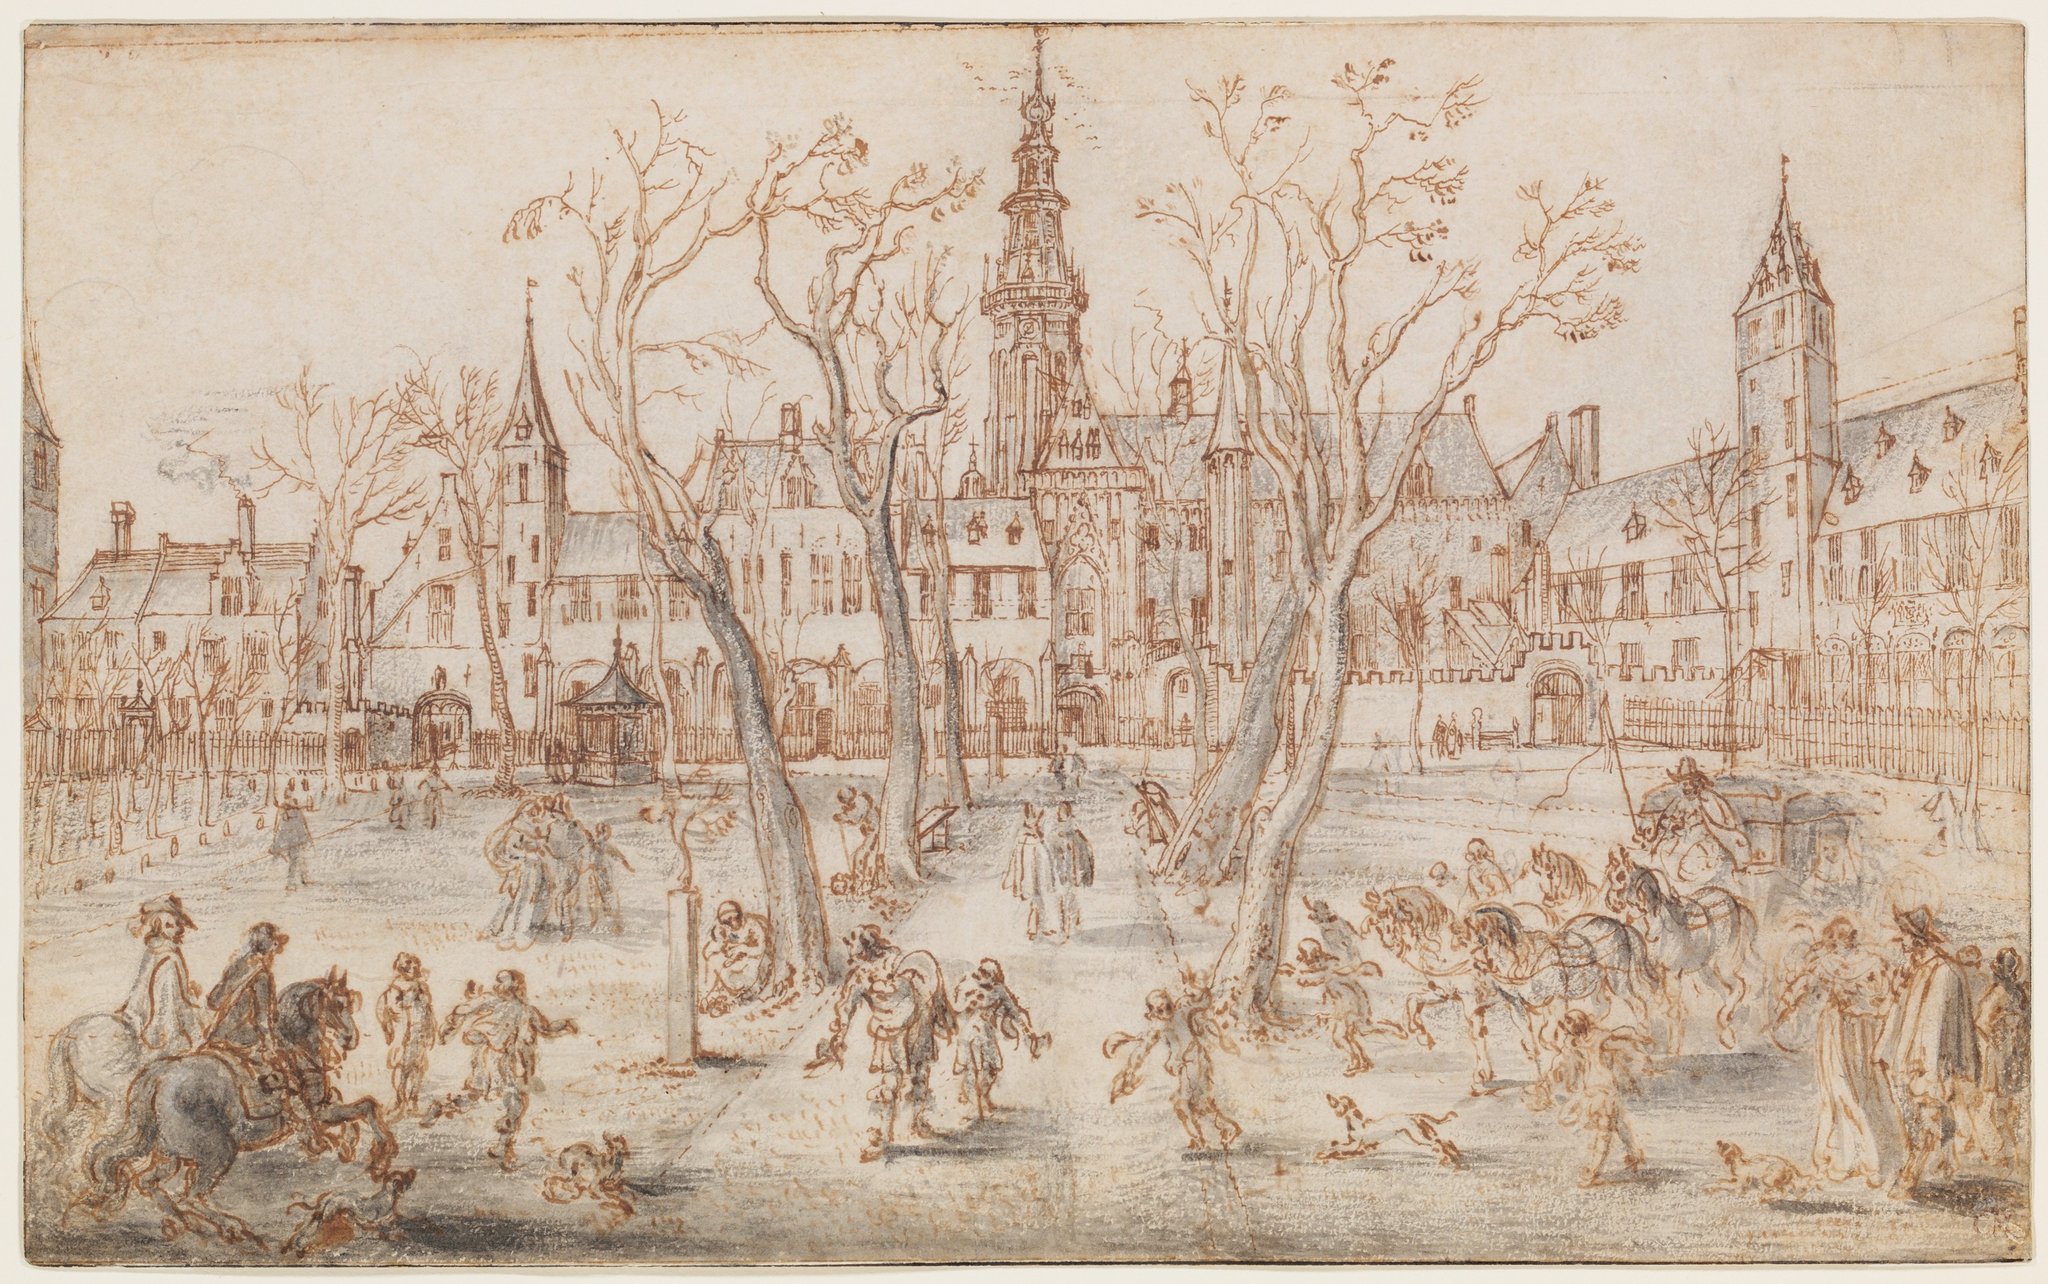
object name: drawing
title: Abdijplein of Middelburg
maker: adriaen pietersz van de venne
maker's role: artist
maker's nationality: dutch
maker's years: 1589-1662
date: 1601-1700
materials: ink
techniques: pen, wash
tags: human figures,buildings,streets,horses,trees